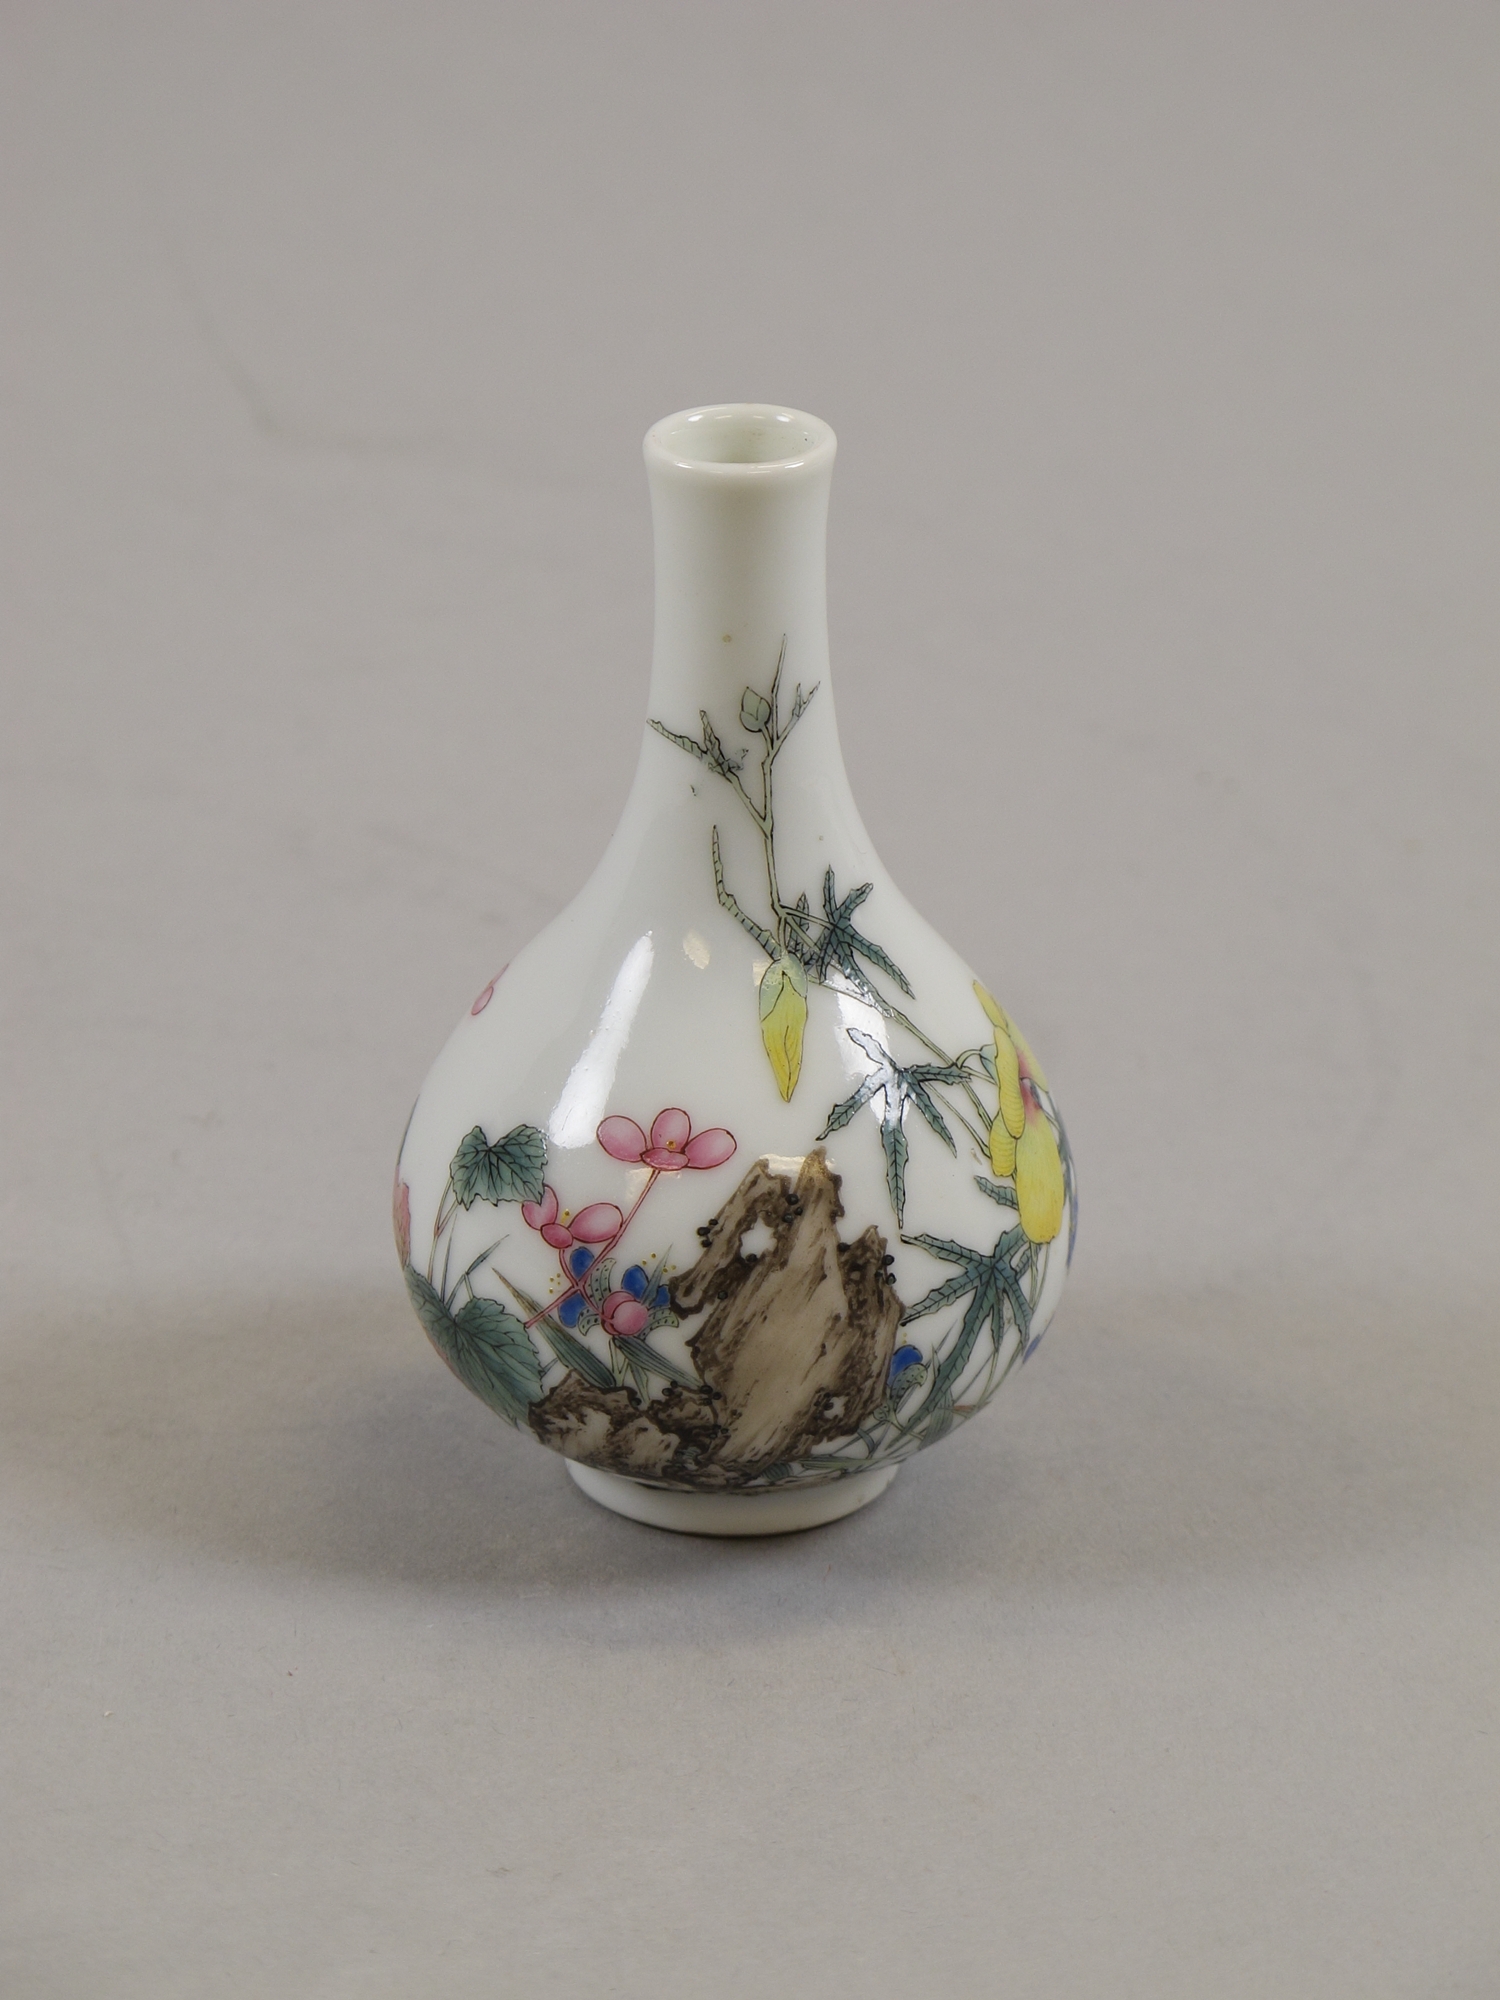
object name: vase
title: Miniature Vase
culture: chinese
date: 1736-1795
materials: enamel, porcelain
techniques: polychrome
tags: flowers,plants,leaves